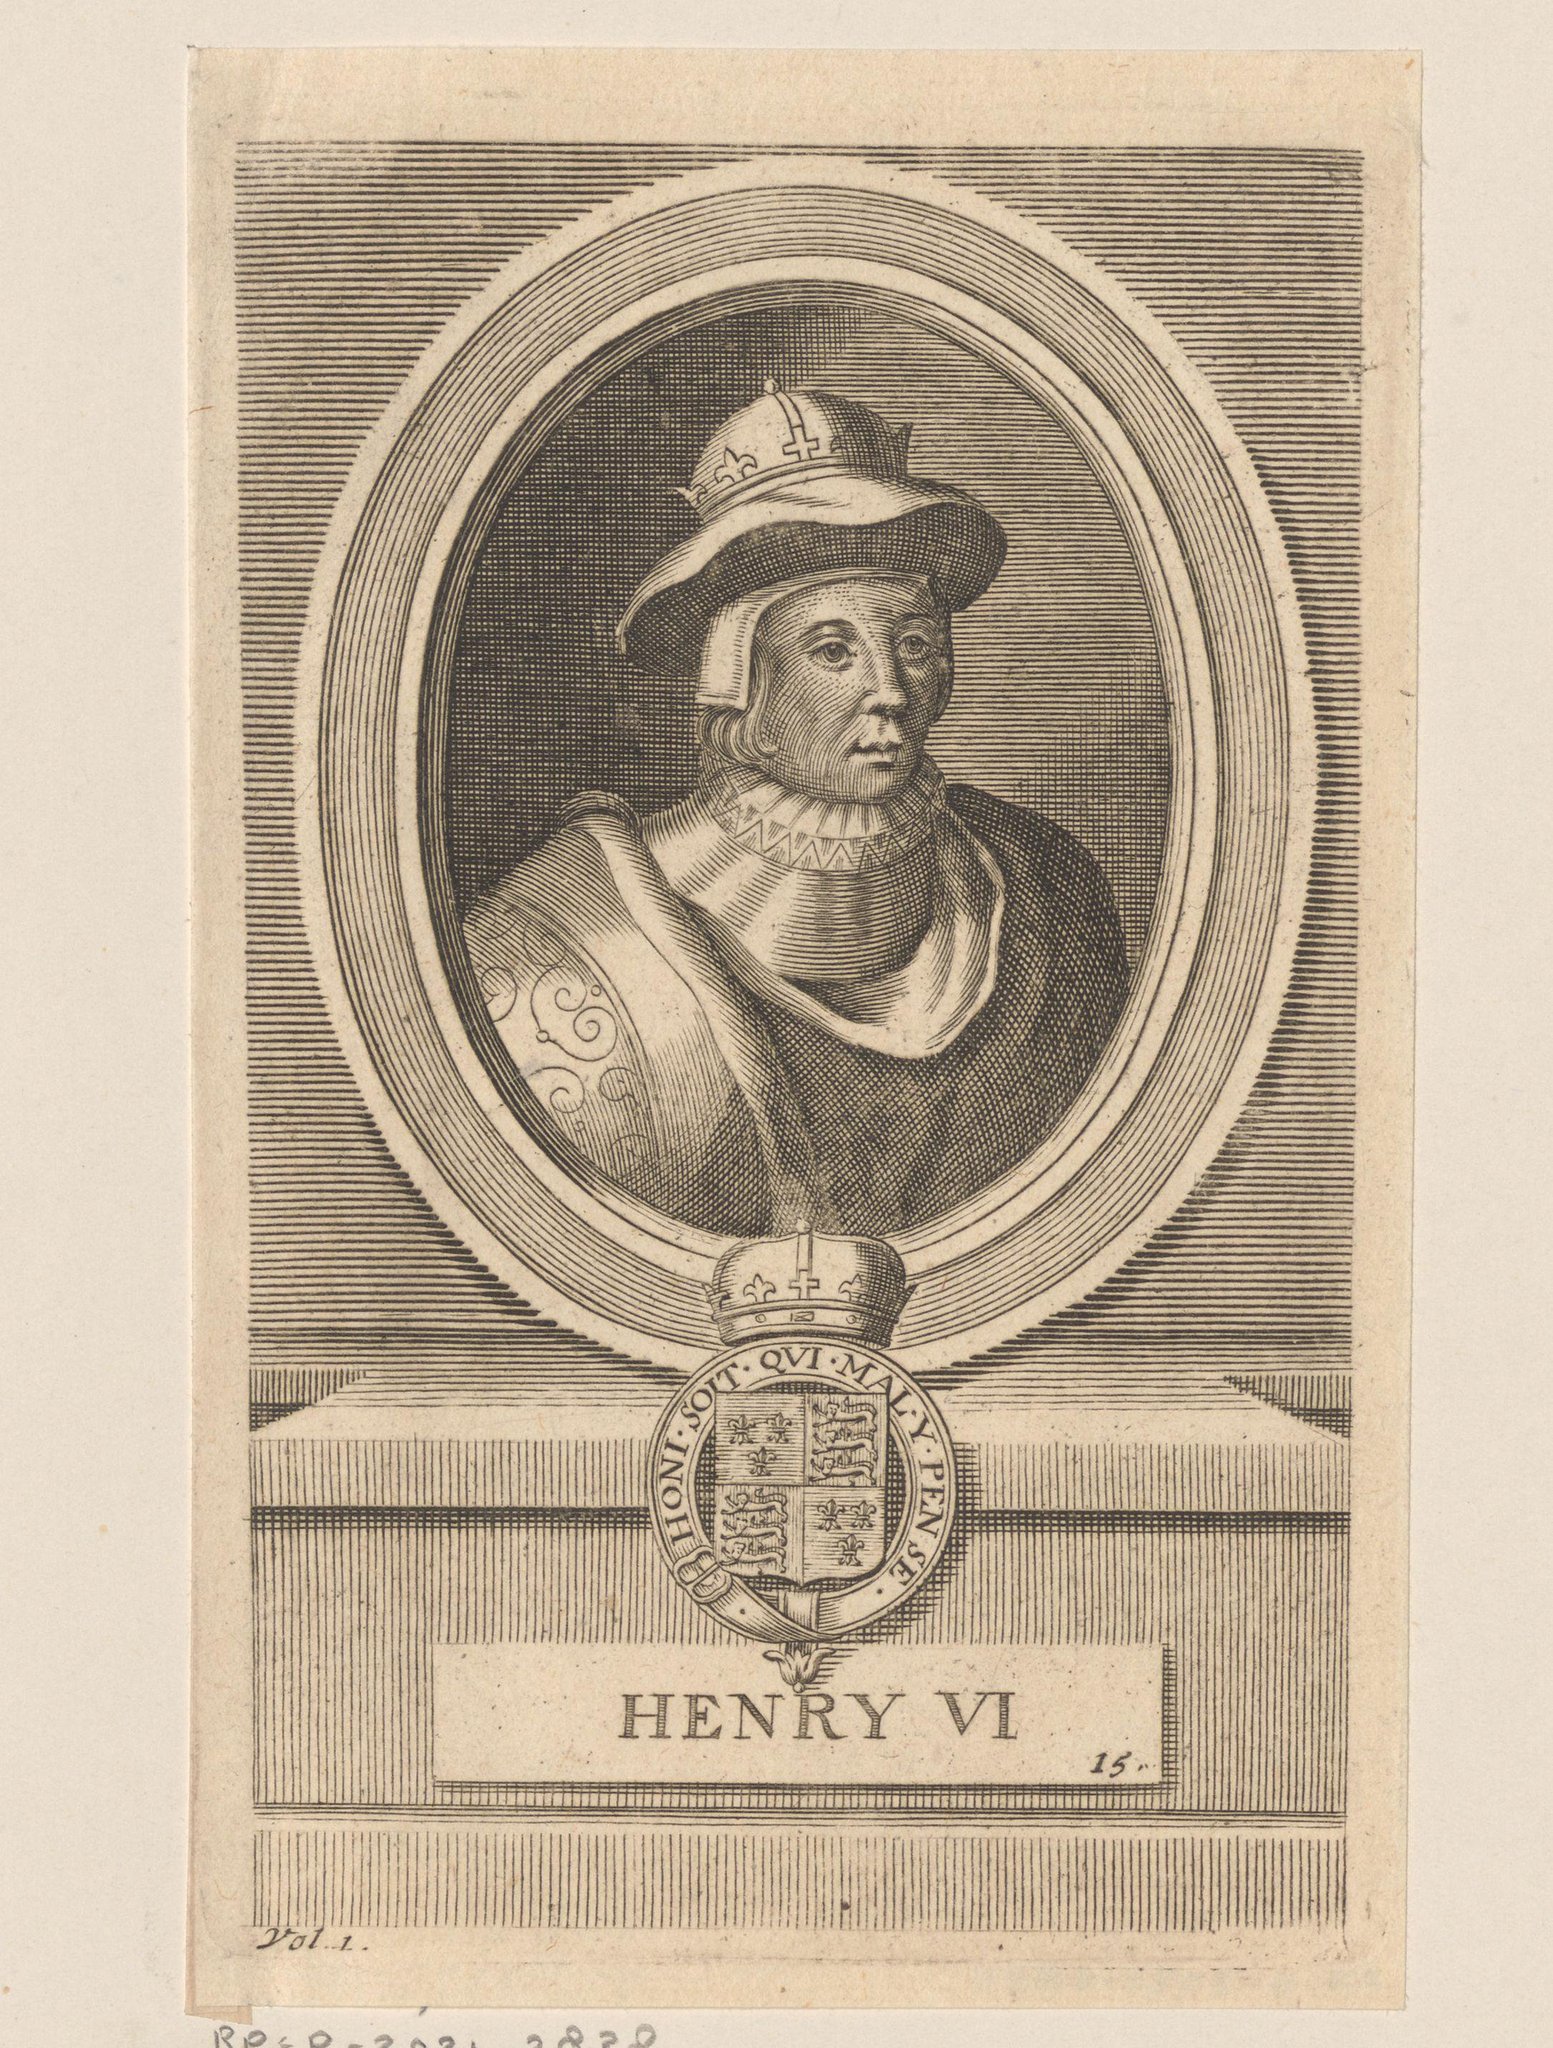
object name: book illustration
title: Portret van Hendrik VI, koning van Engeland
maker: Anonymous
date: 1700-1749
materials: paper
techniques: engraving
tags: london, historical persons, king, armorial bearing, heraldry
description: Prent gebruikt in: The history of England. Faithfully extracted from authentick records (…). Londen: Isaac Cleaver, 1715, dl. 1. Prent mogelijk ook gebruikt in andere edities van dit werk of andere publicaties.